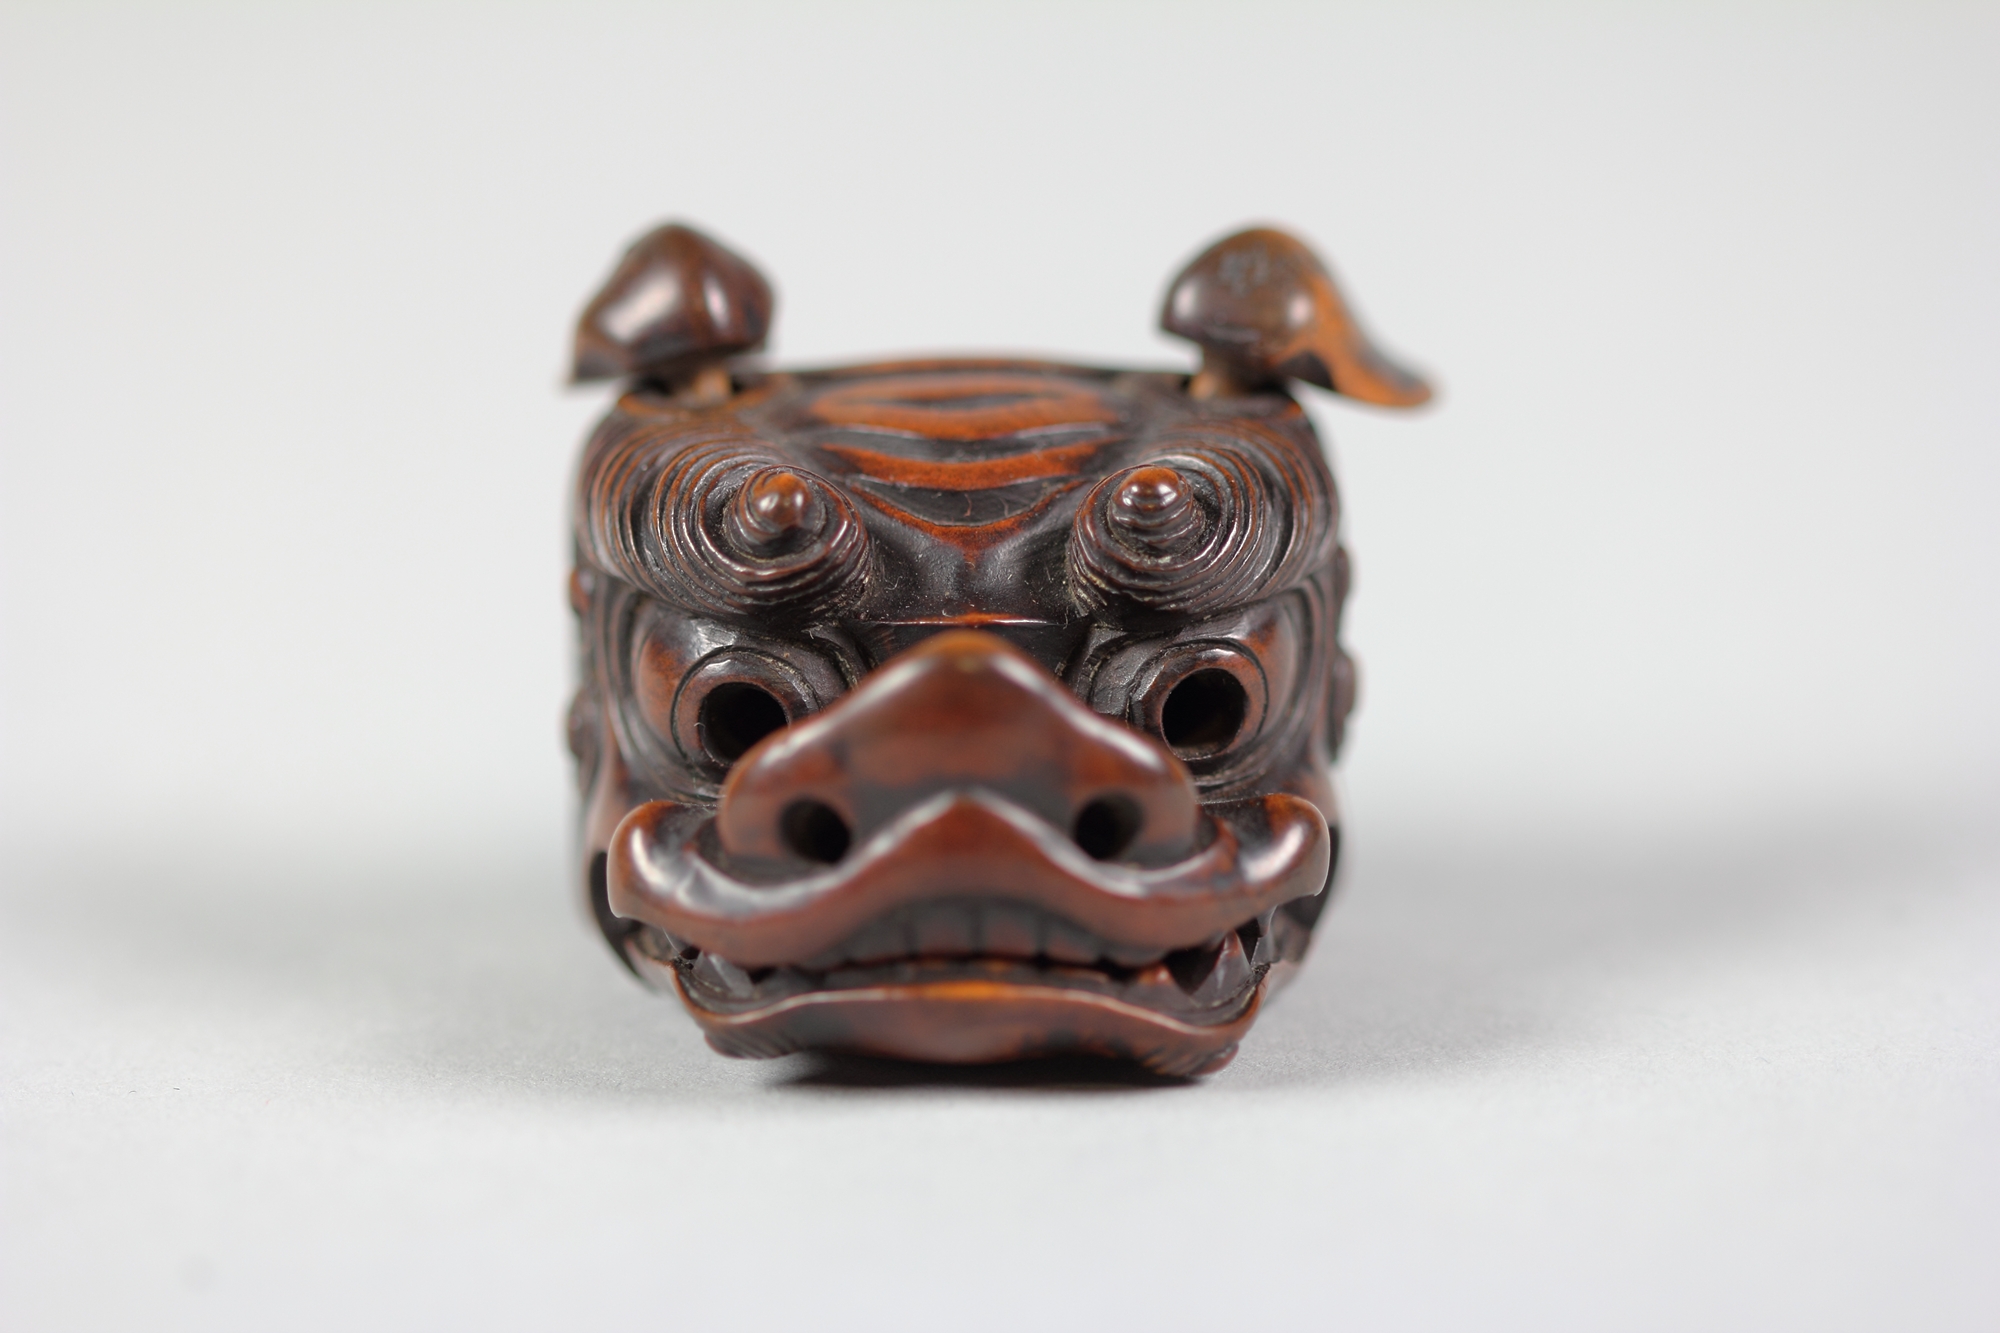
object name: netsuke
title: Netsuke of Lion Mask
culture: japanese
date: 1801-1900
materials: wood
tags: masks,lions